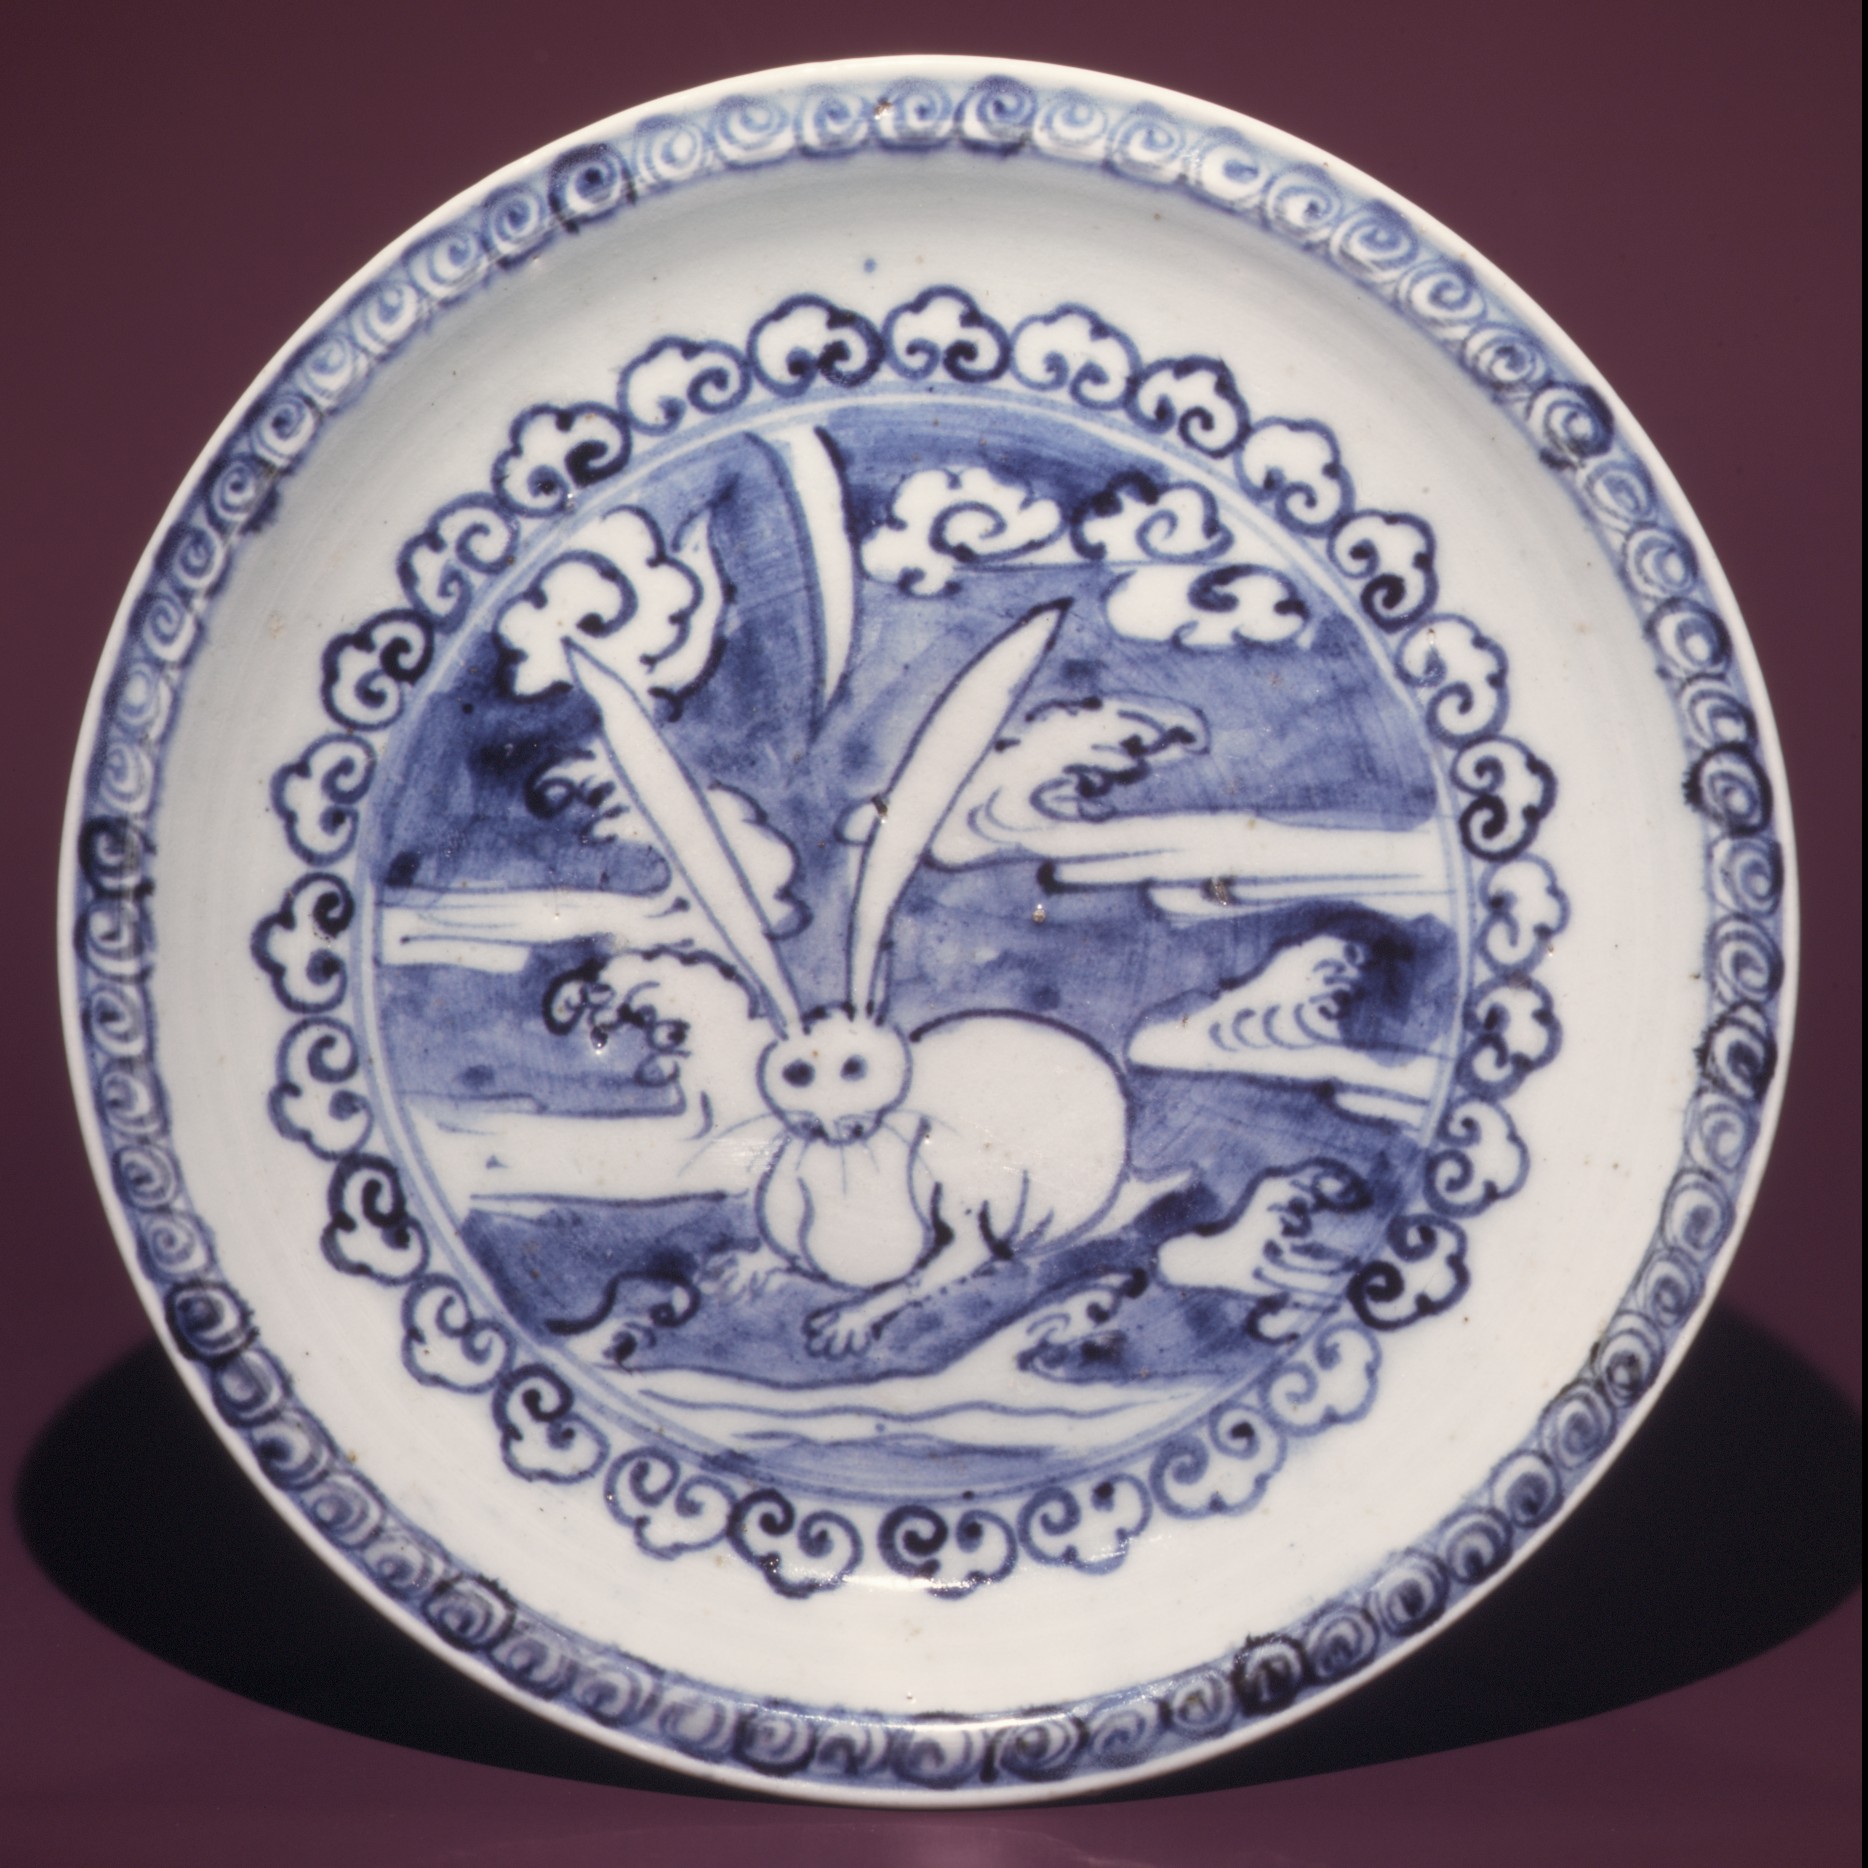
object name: dish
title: Dish with Design of Hare in Clouds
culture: japanese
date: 1624-1643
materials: porcelain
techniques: underglaze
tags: rabbits